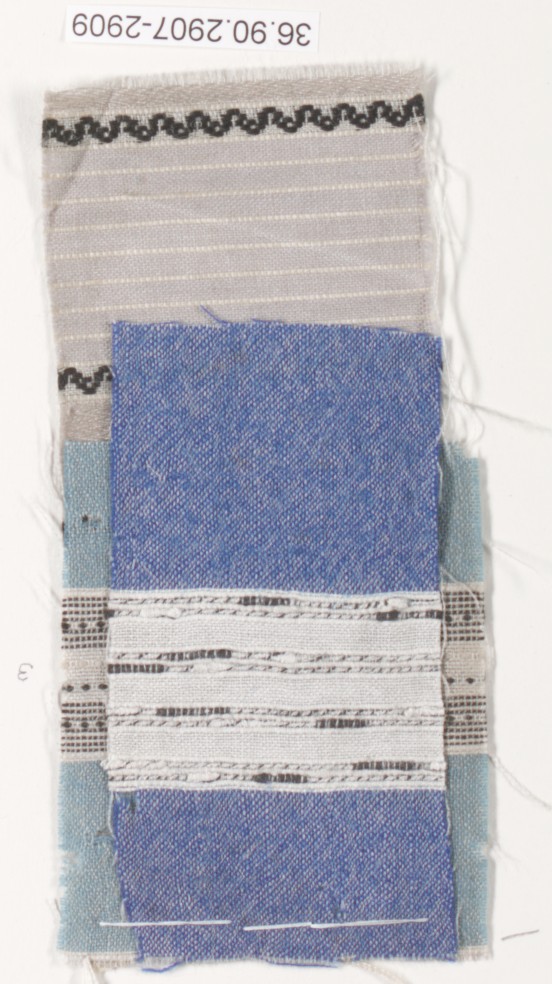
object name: piece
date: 1801-1900